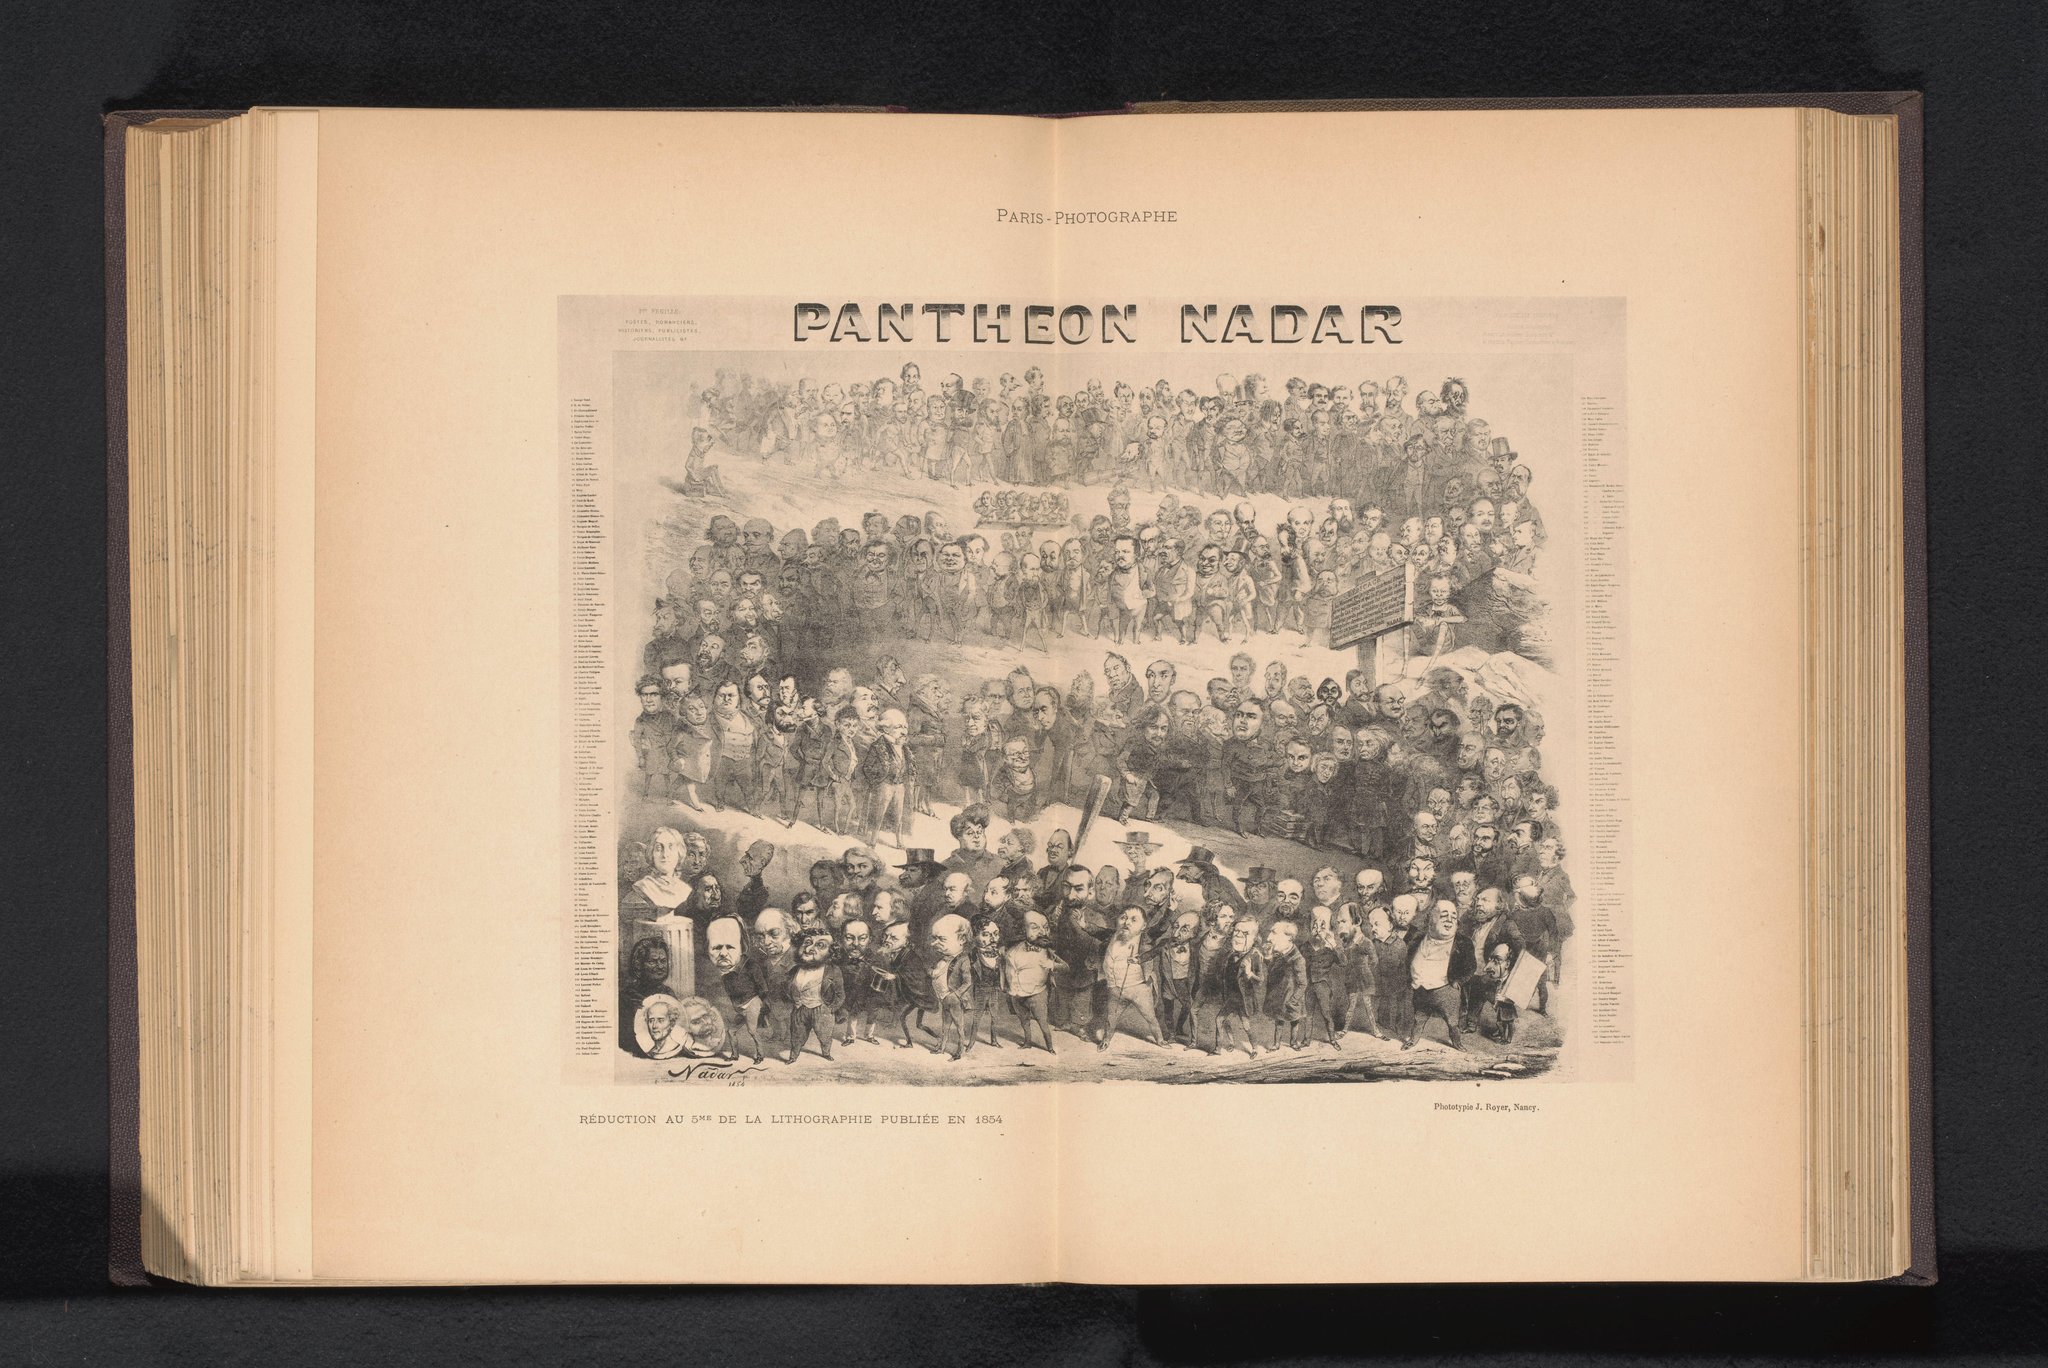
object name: reproduction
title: Pantheon Nadar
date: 1882-1892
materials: paper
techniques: photograph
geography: nancy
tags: caricatures (human types), artist (in general)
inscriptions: inscription: ‘R'duction au 5me de la lithographie publiée en 1854’